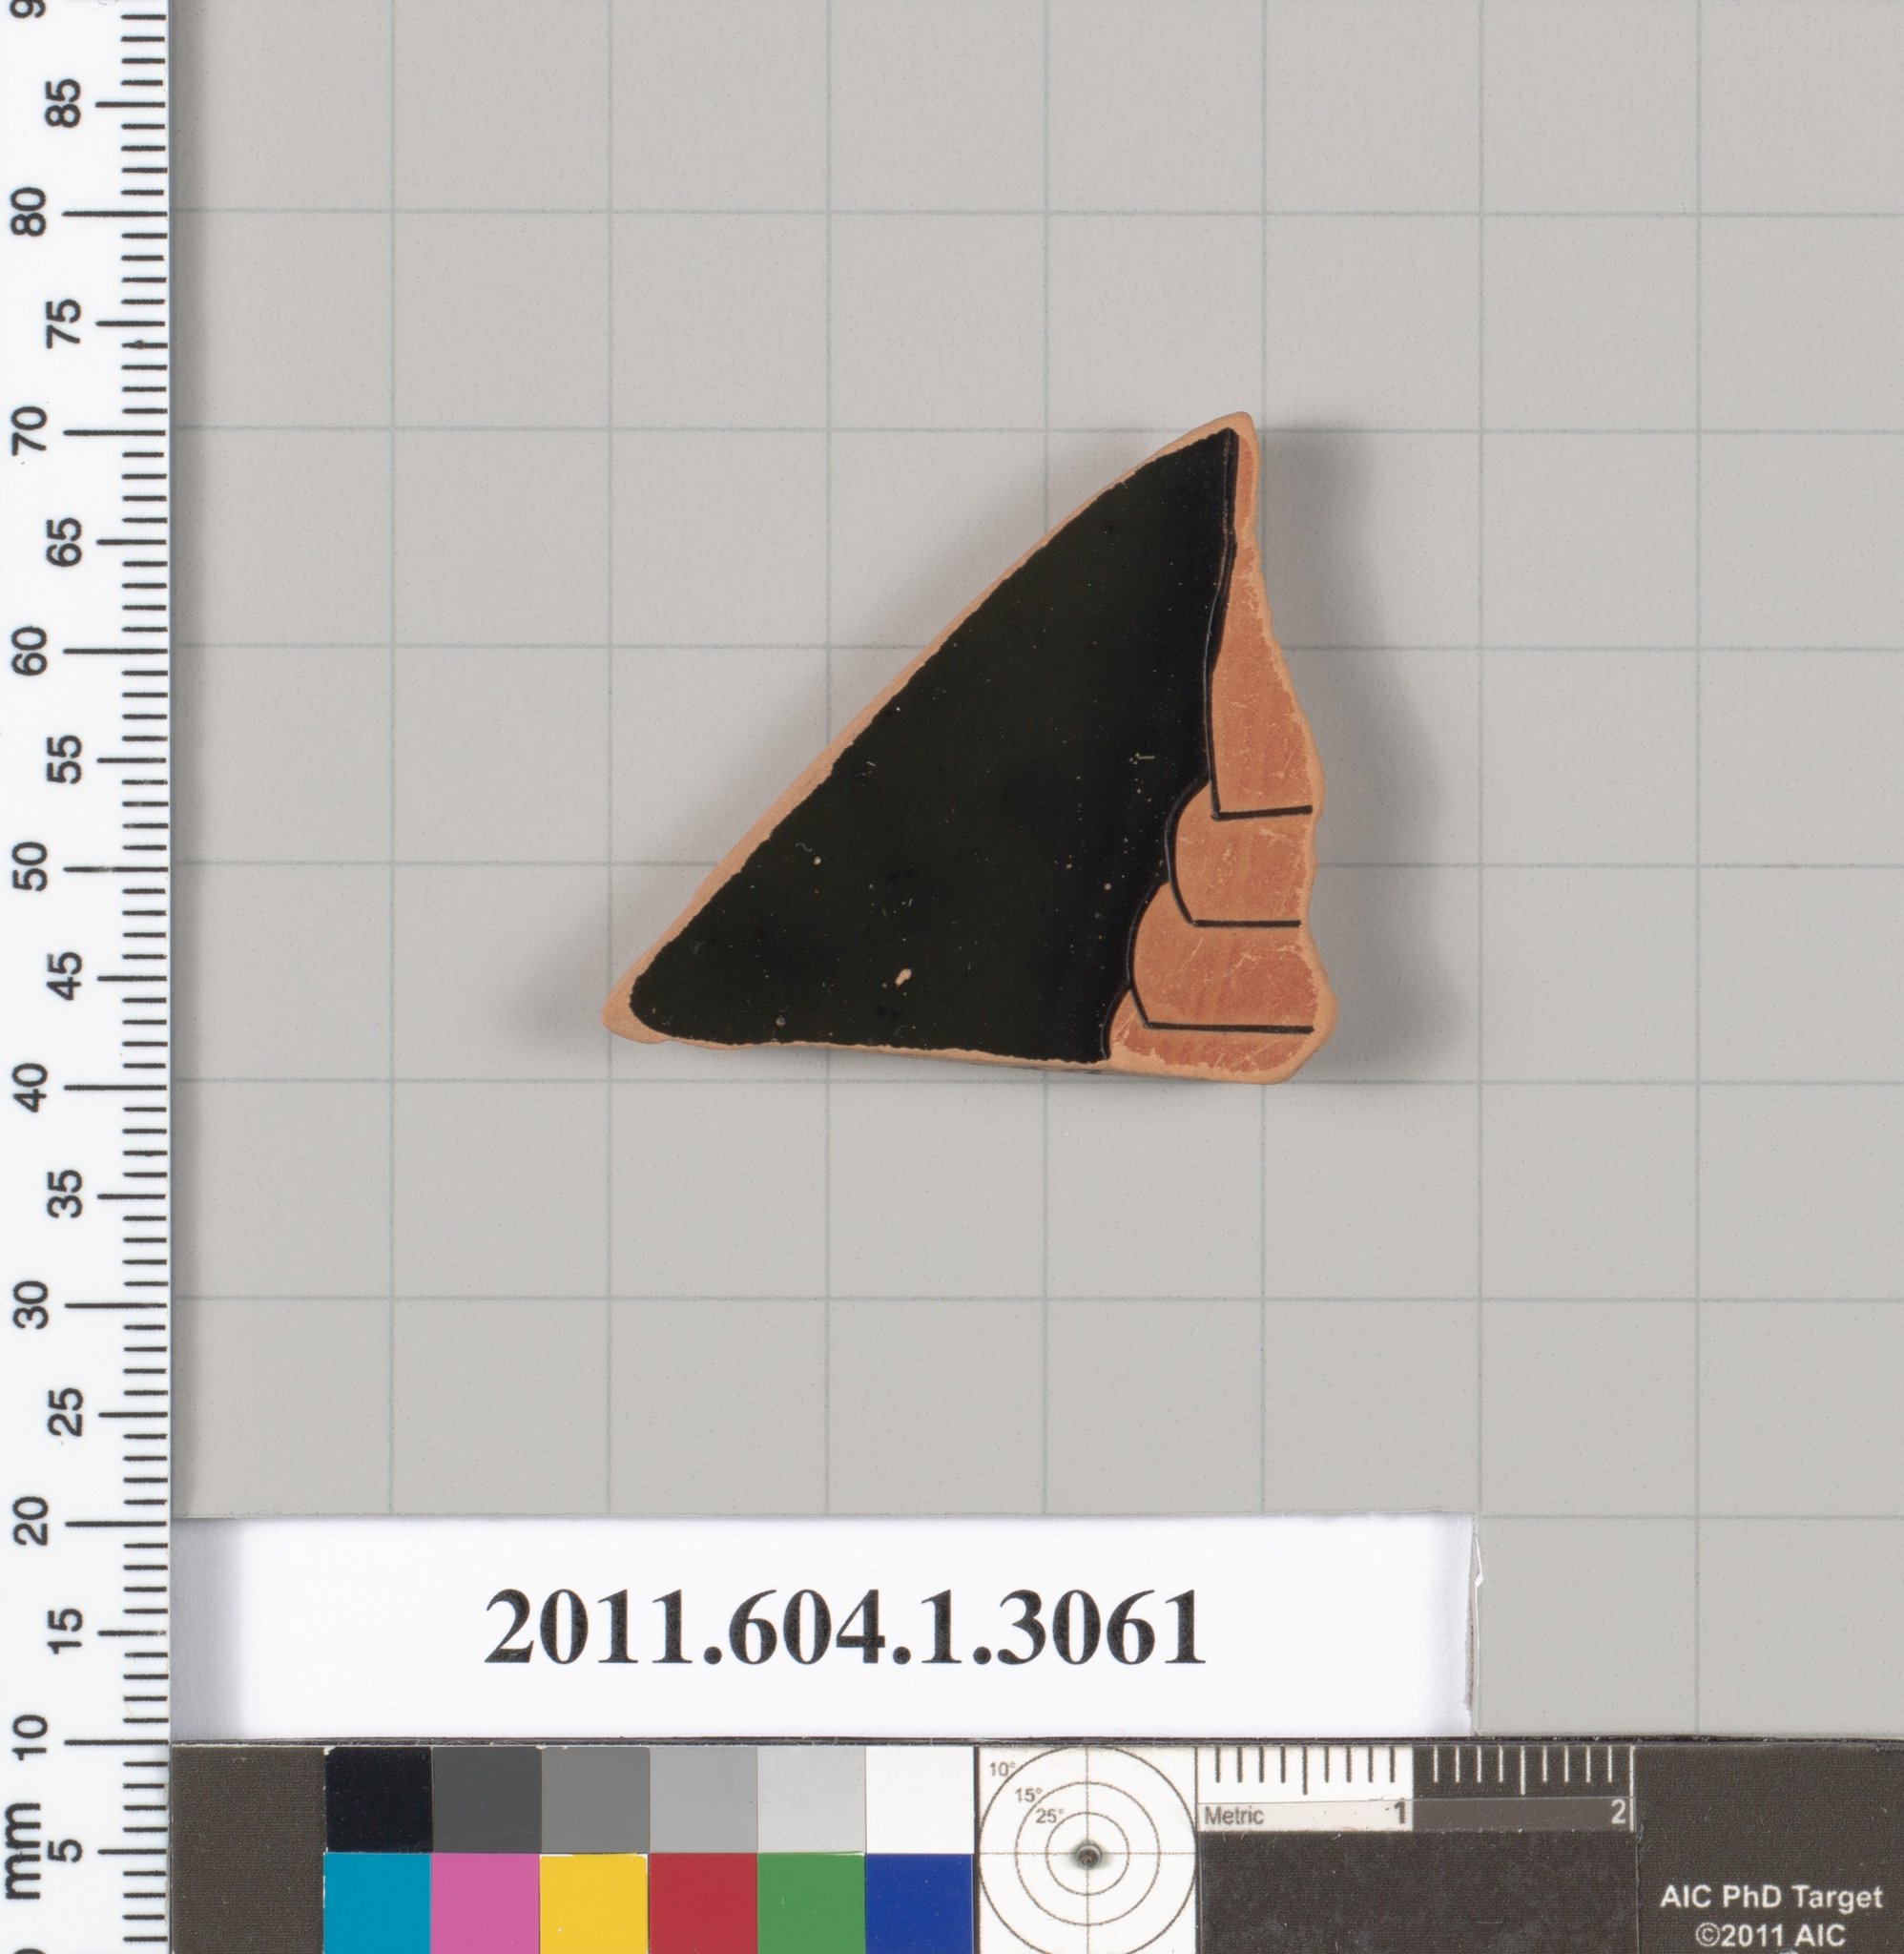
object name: kylix fragment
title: Terracotta fragment of a kylix (drinking cup)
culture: greek, attic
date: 490-480 BCE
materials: terracotta